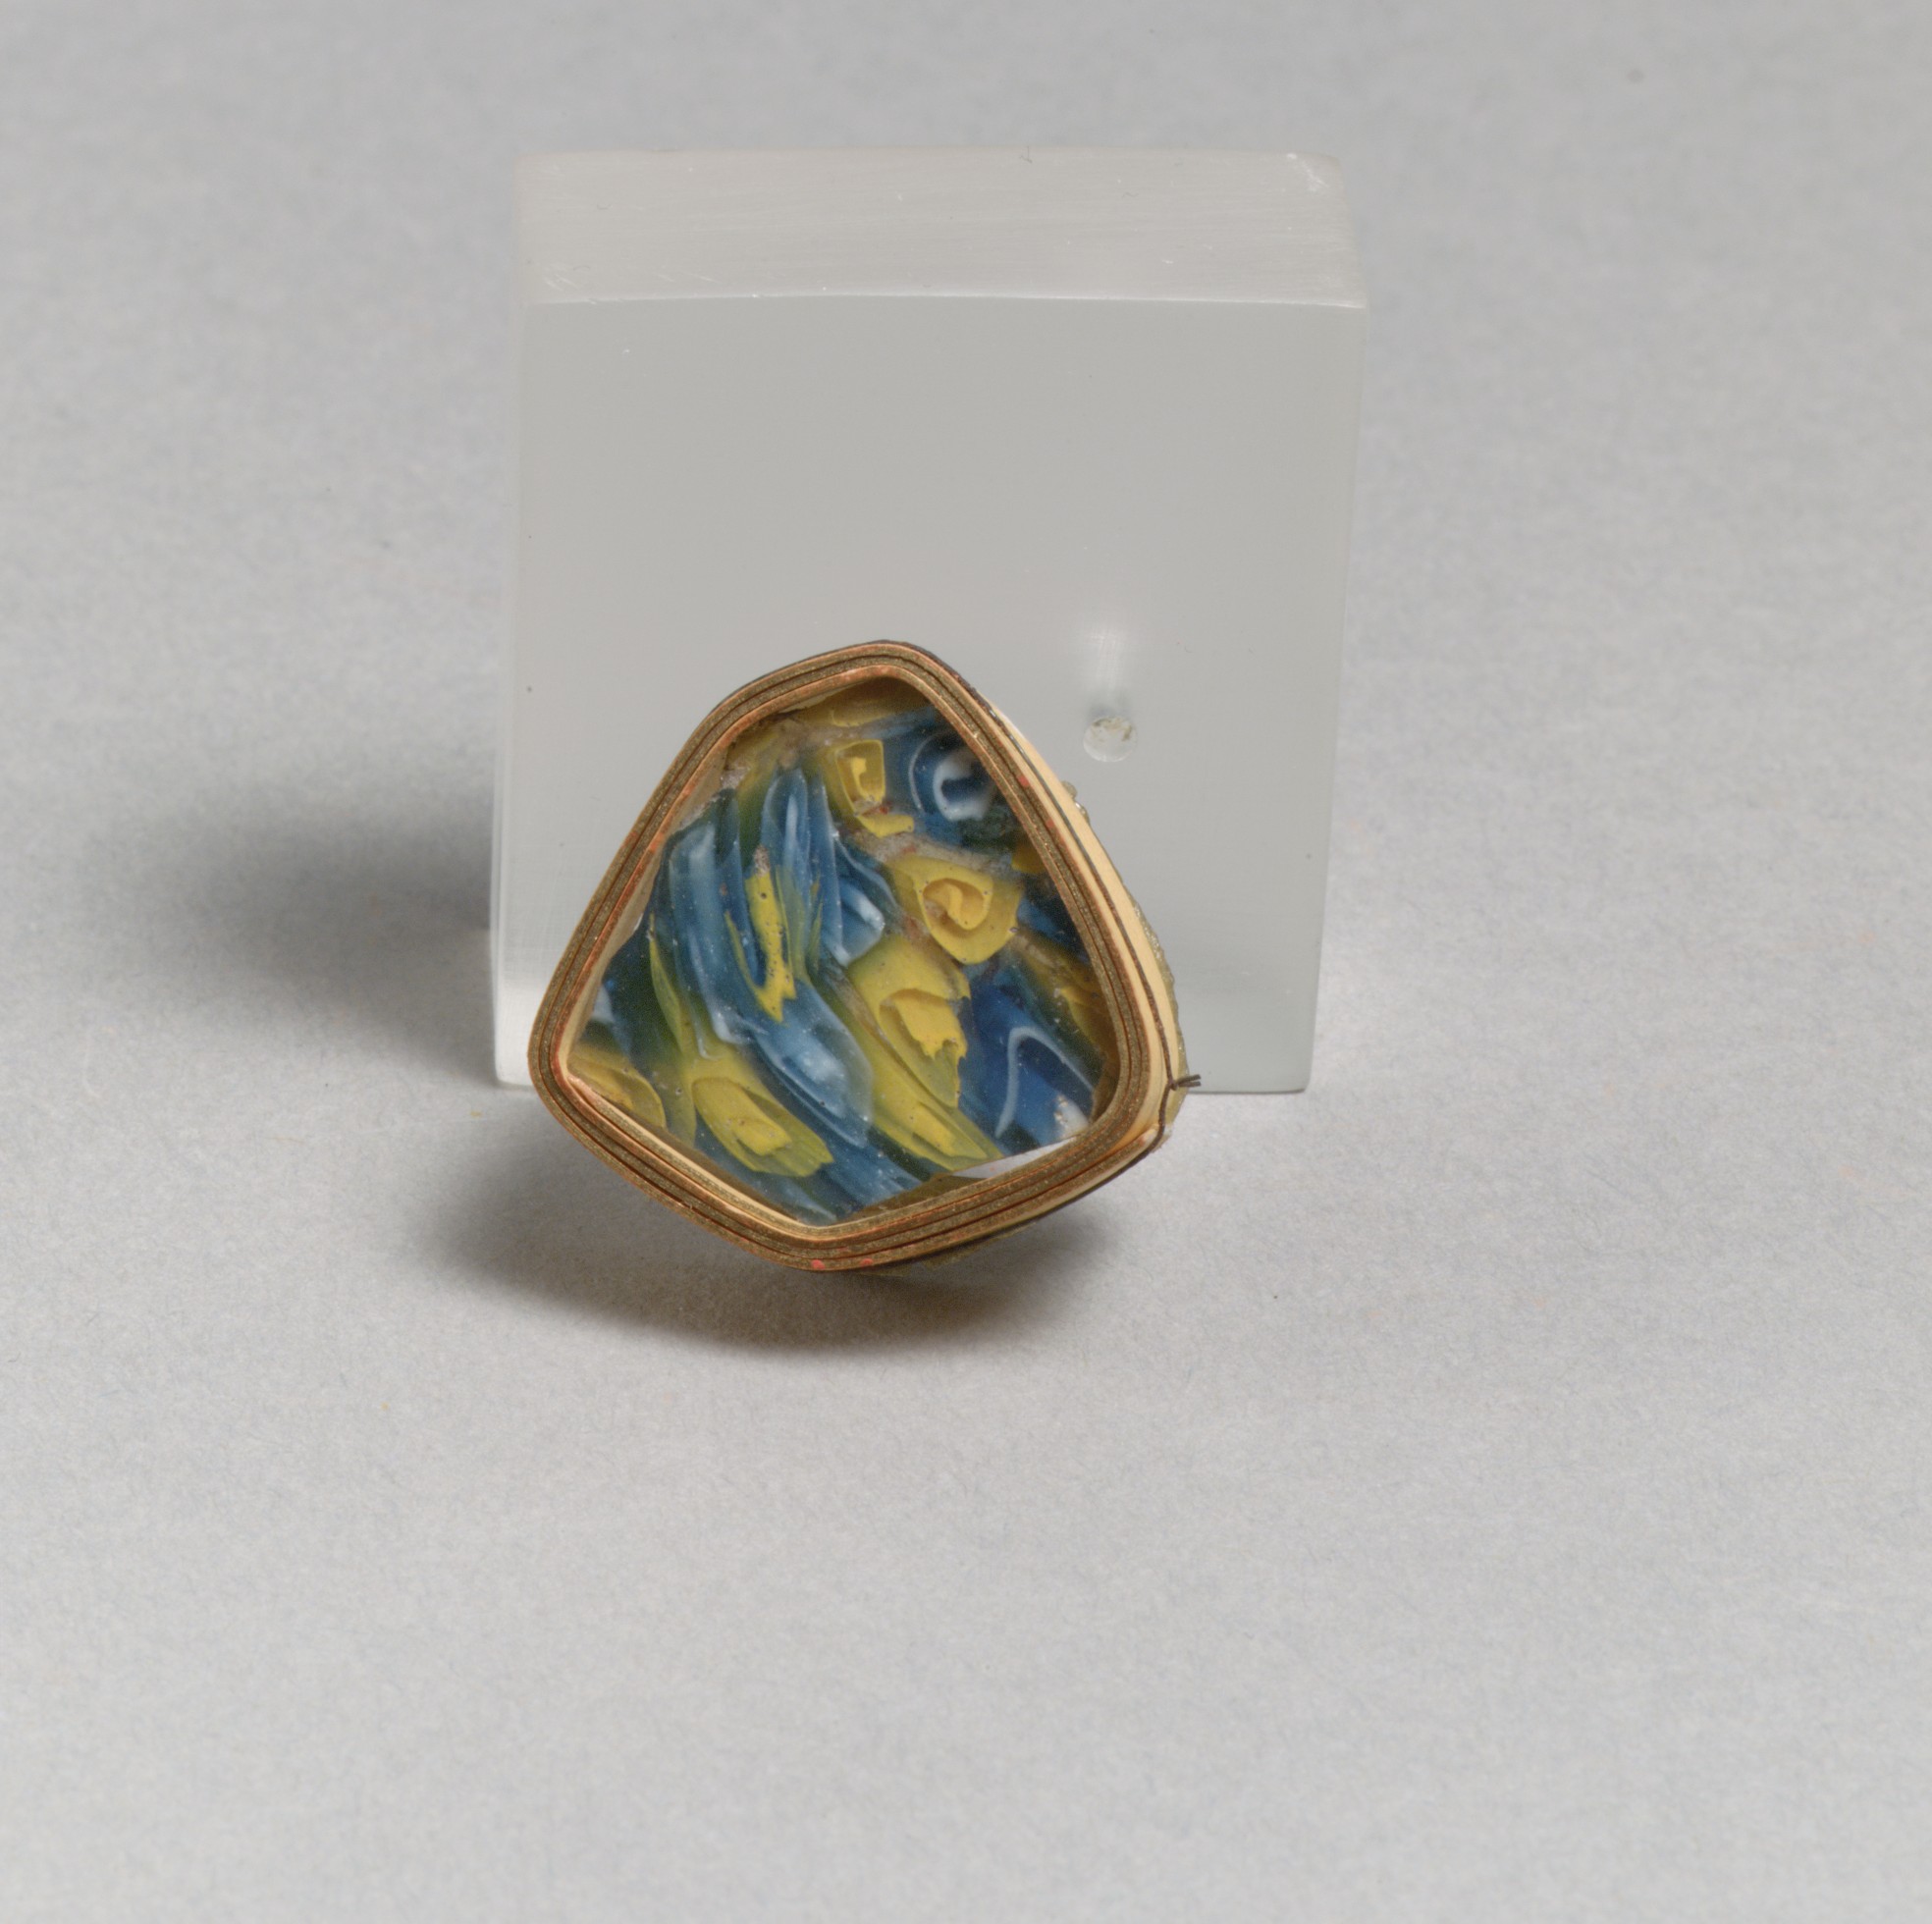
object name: fragment, mosaic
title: Mosaic glass fragment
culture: roman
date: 34 BCE-33 CE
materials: glass